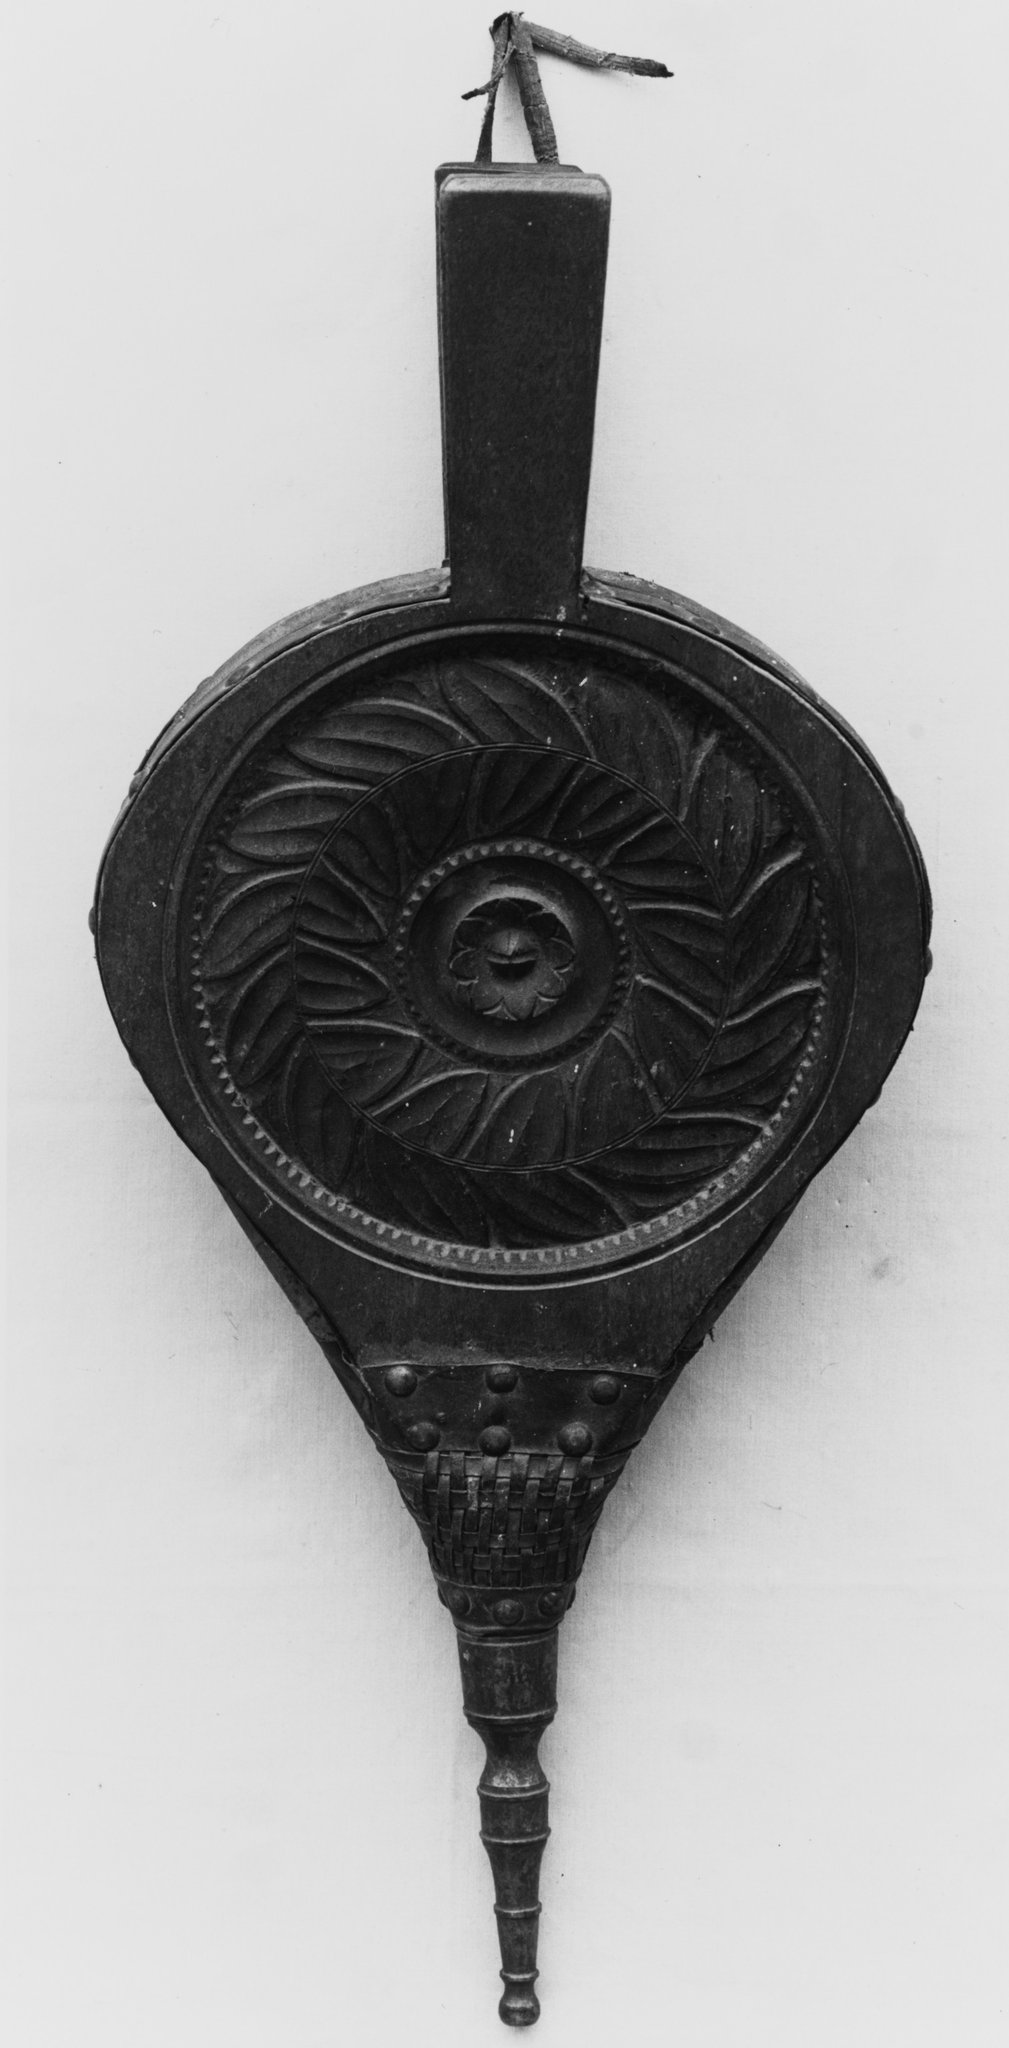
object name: bellow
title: Bellows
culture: american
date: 1700-1900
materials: brass, leather, wood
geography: united states